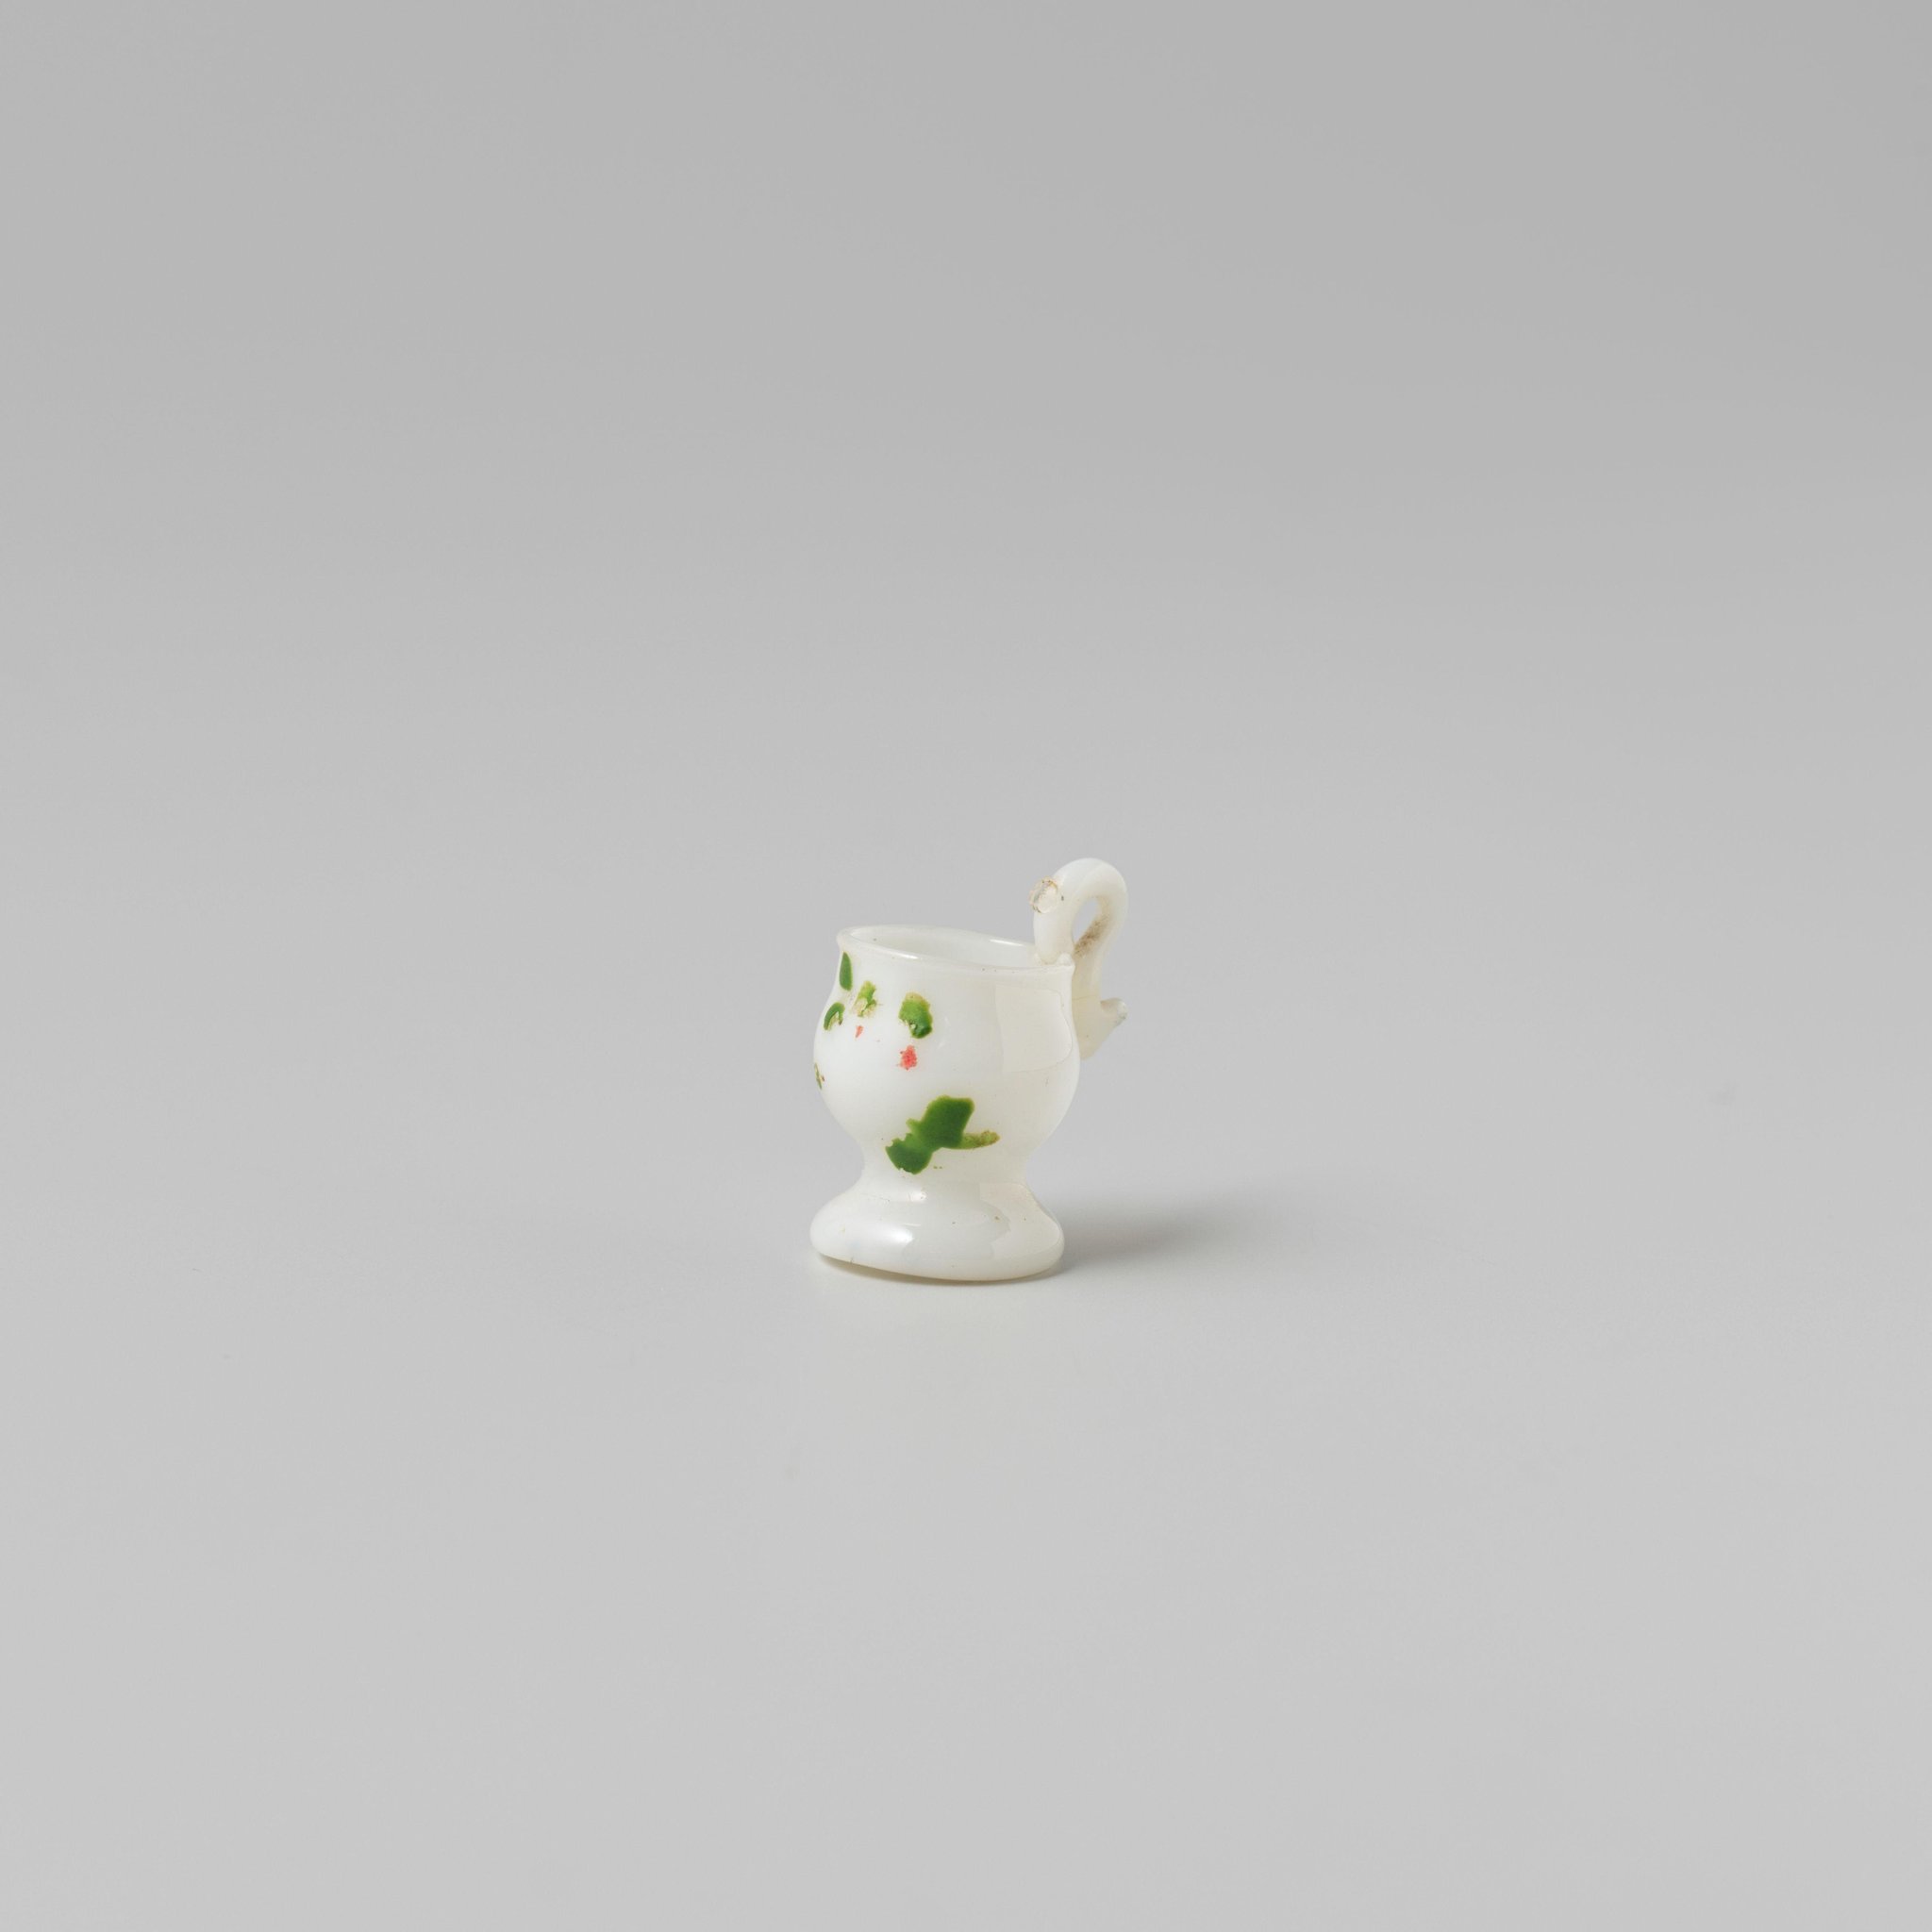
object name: cup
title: Kop met oor, beschilderd met bloem in wit, rood en groen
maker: Anonymous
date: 1800-1849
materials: glass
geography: bristol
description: Kop van opaak wit glas, bol model op voet, met s-vormig oor. De kop is beschilderd met een bloem in wit, rood en groen.